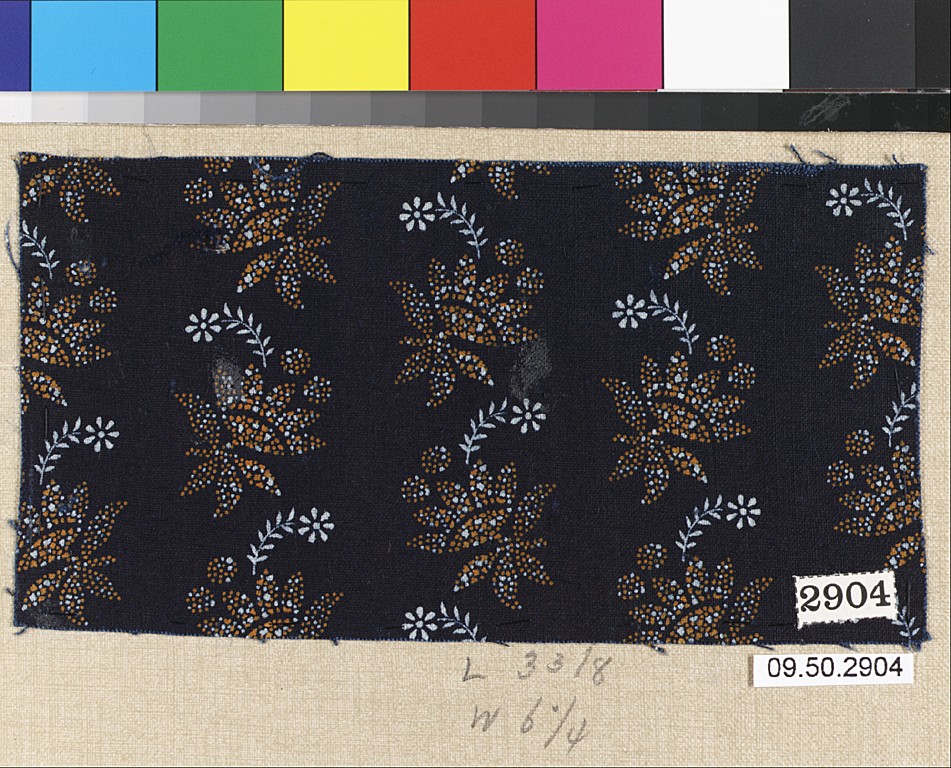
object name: piece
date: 1801-1900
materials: cotton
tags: flowers,leaves